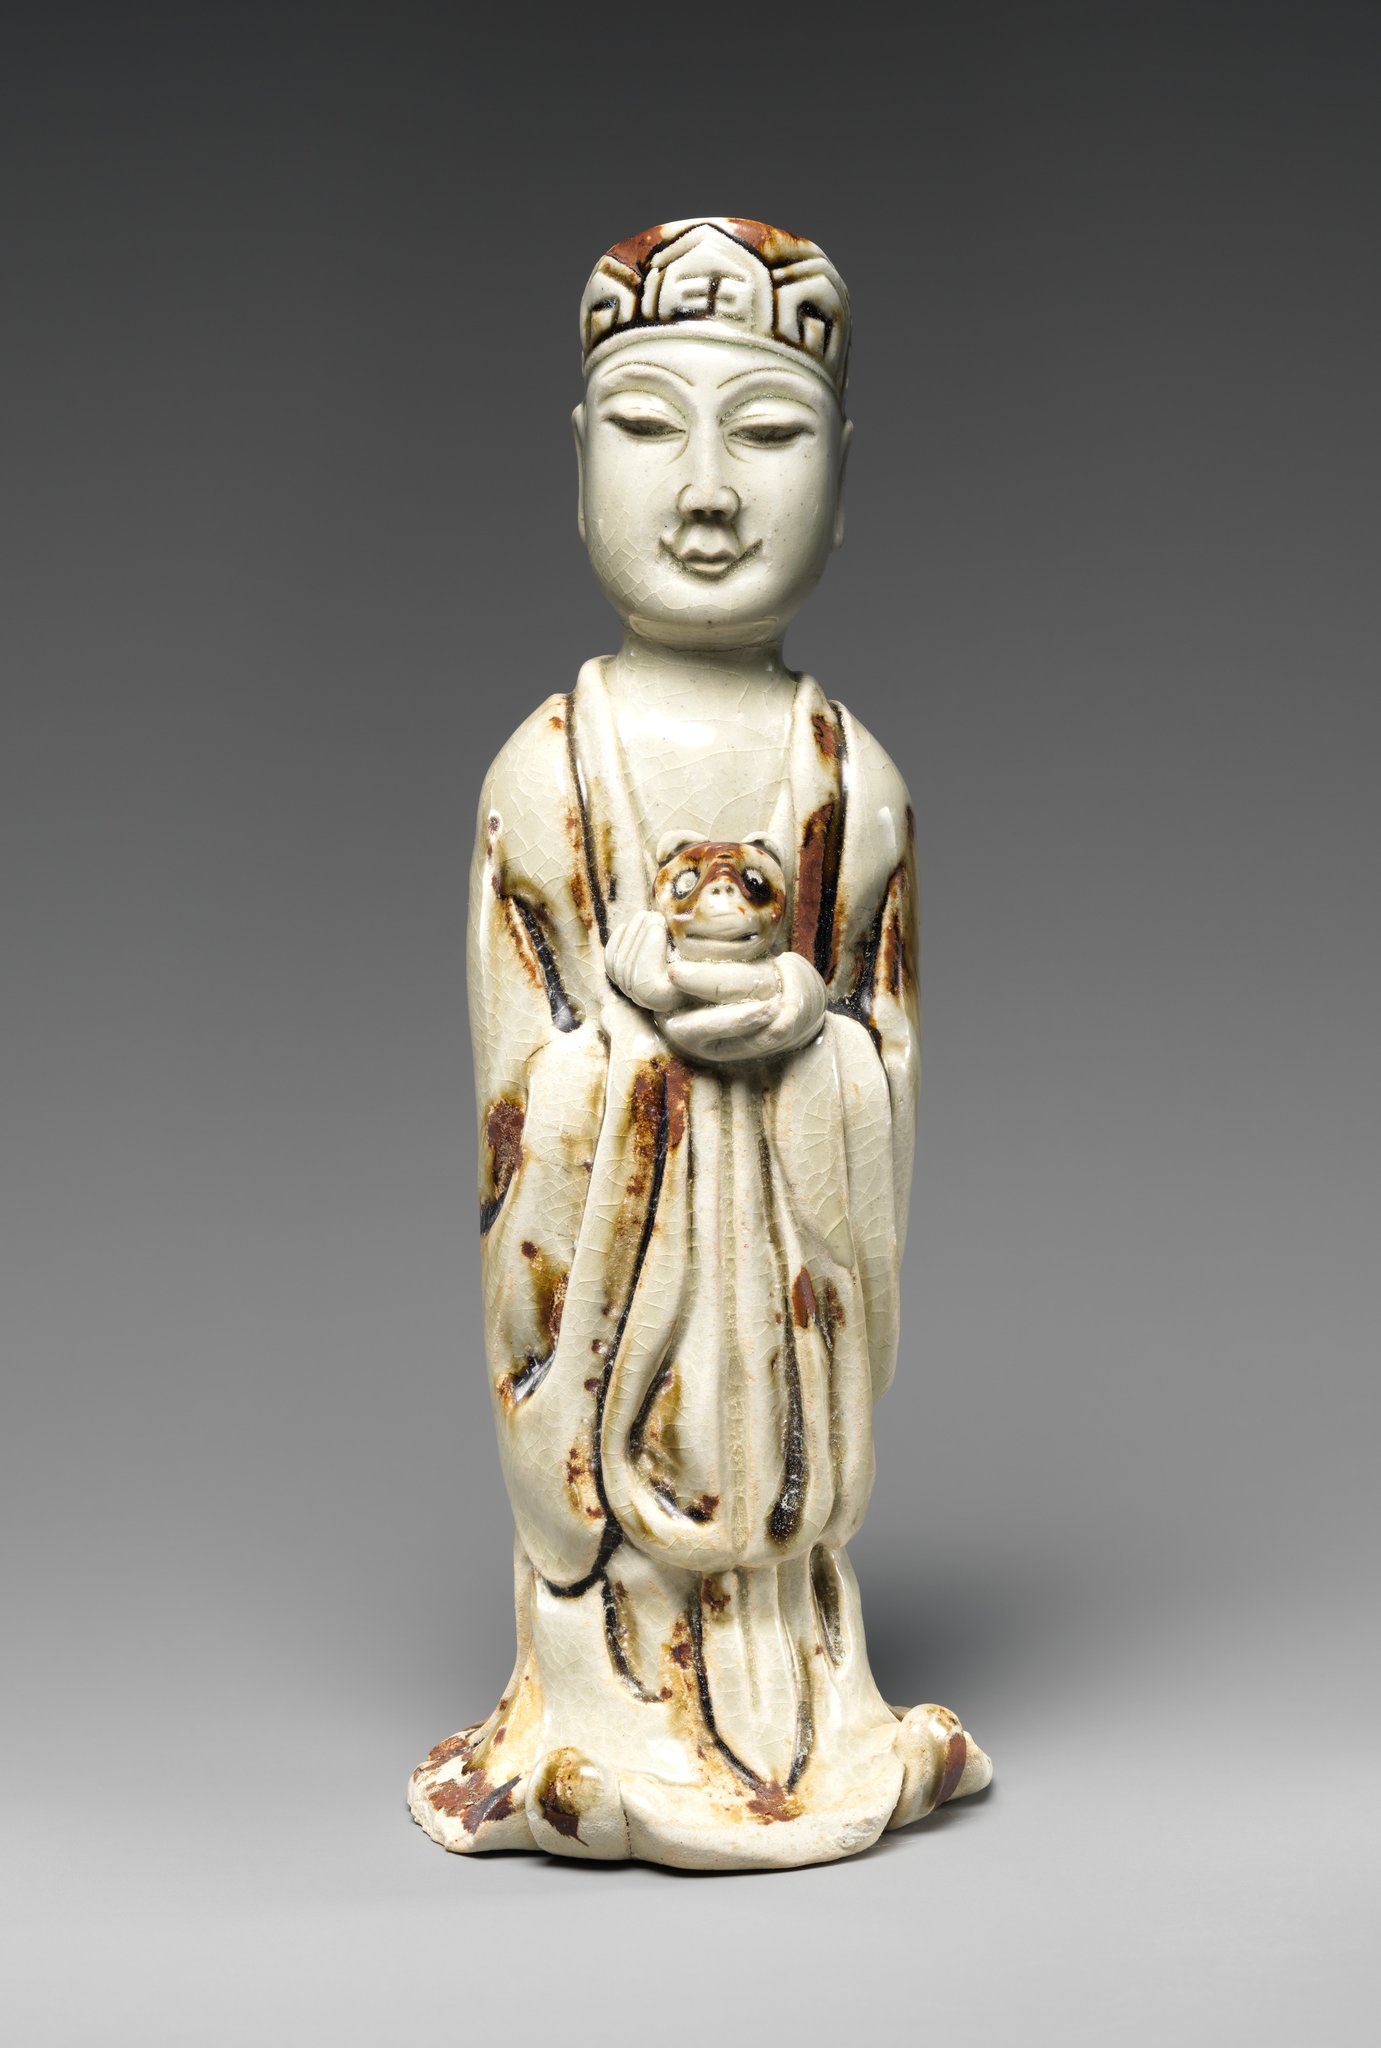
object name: figure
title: Zodiac figure of a tiger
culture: chinese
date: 960-1279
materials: stoneware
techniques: glazing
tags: men,tigers,zodiac